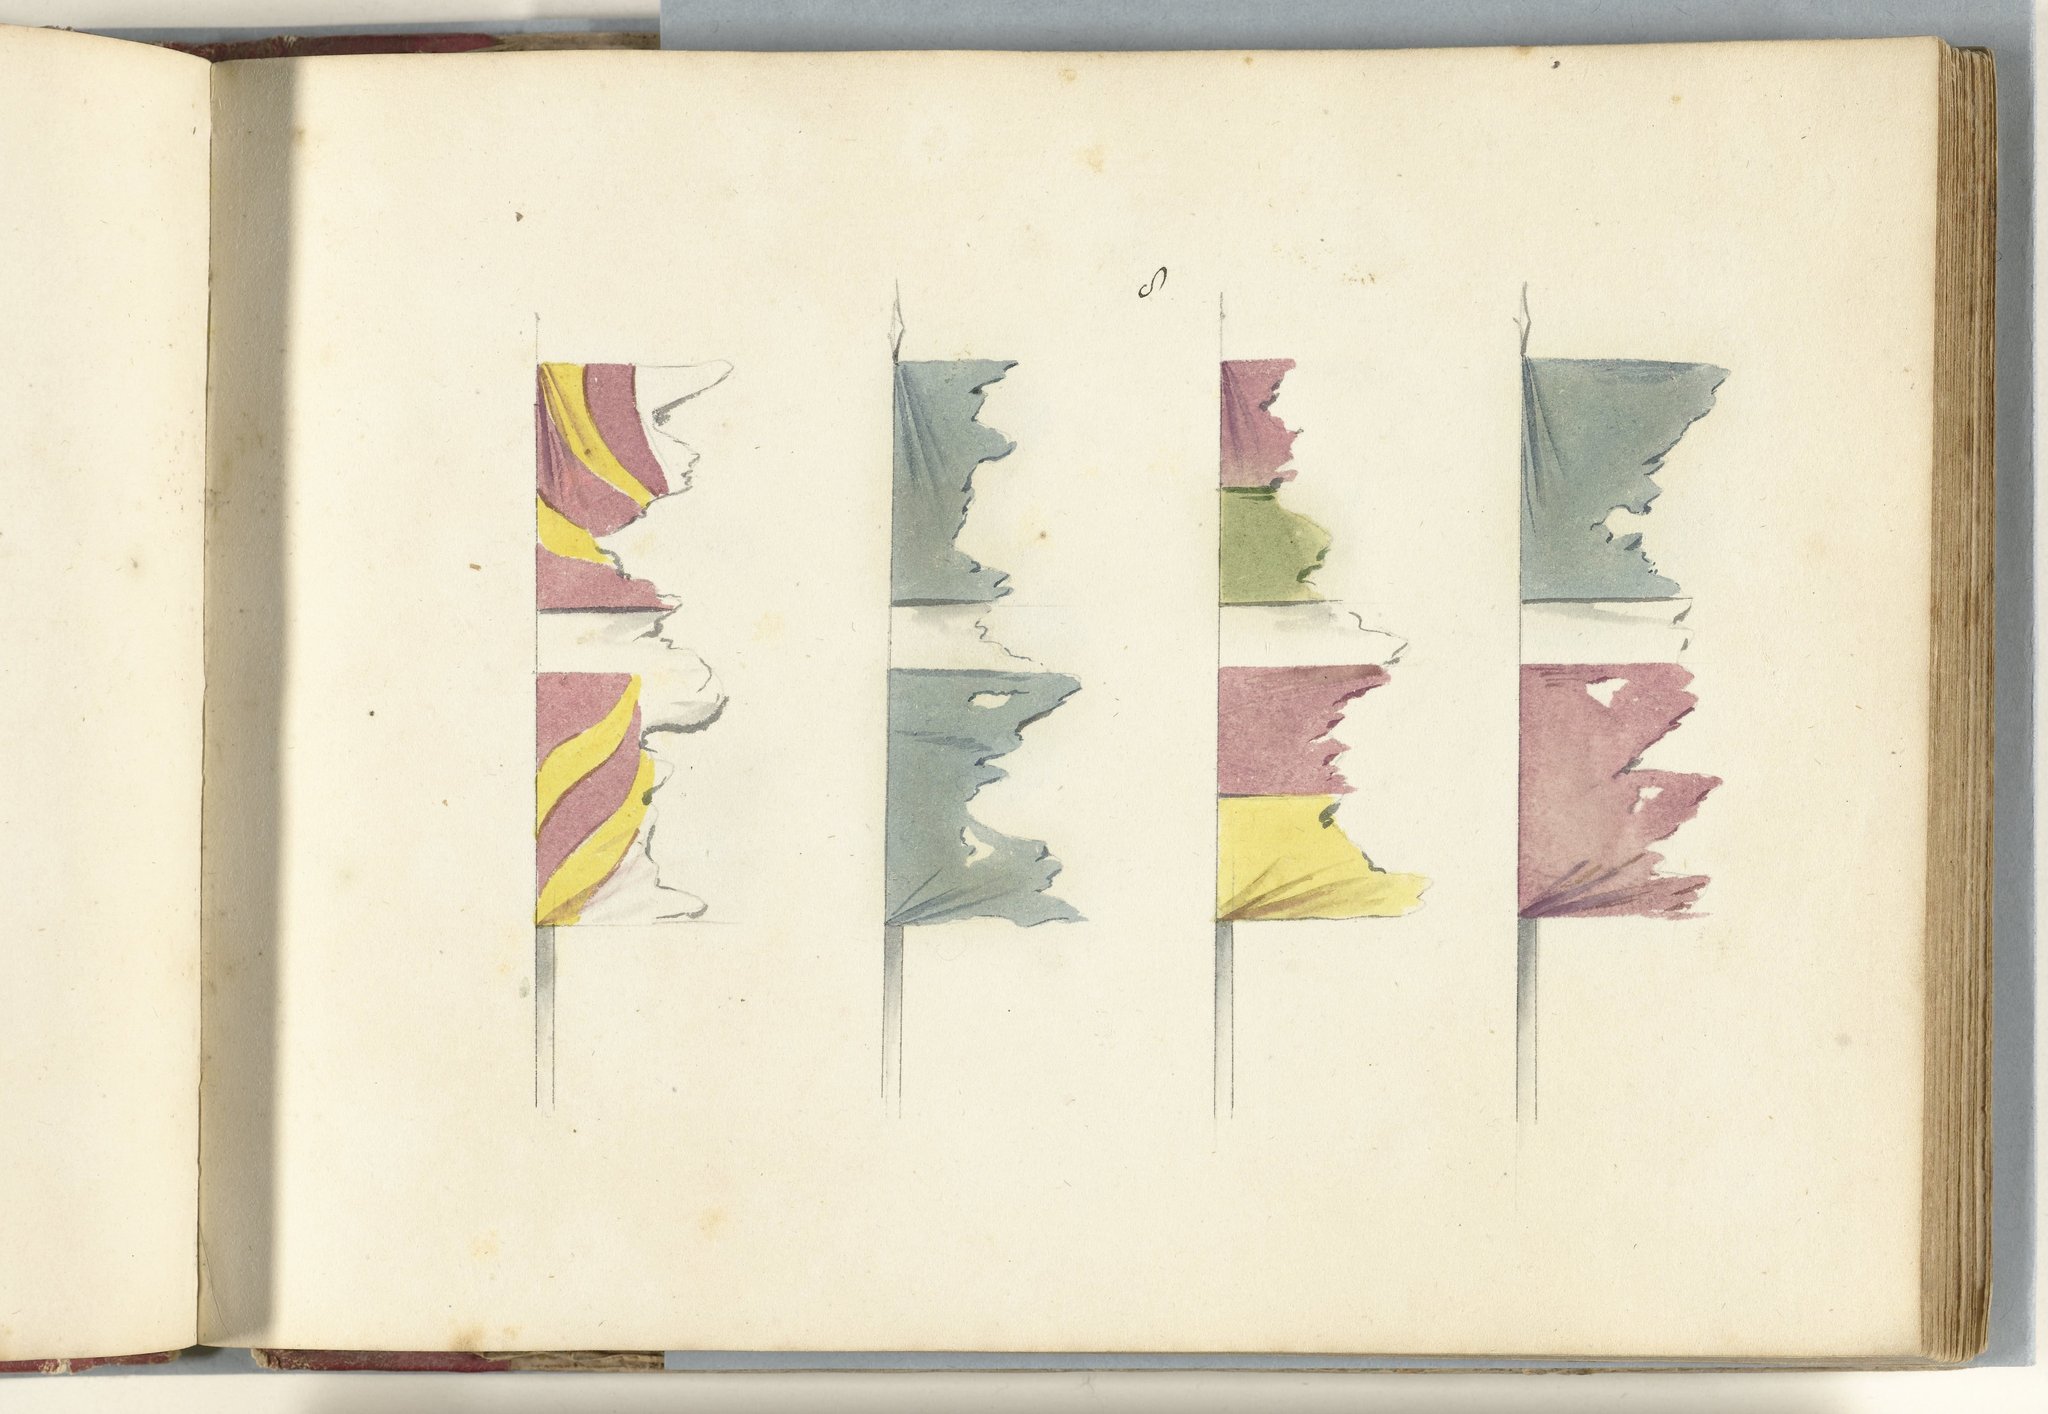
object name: drawing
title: Vier Franse vaandels in flarden, veroverd in de slag bij Oudenaarde, 1708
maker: Anonymous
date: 1713-1720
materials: paper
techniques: drawing, writing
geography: northern netherlands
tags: (military) flags and standards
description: Vier Franse vaandels in flarden, veroverd bij de slag bij Oudenaarde in 1708. In het boek met tekeningen van Franse vaandels, standaarden en pauken, veroverd tijdens de Spaanse Successieoorlog (1701-1713).